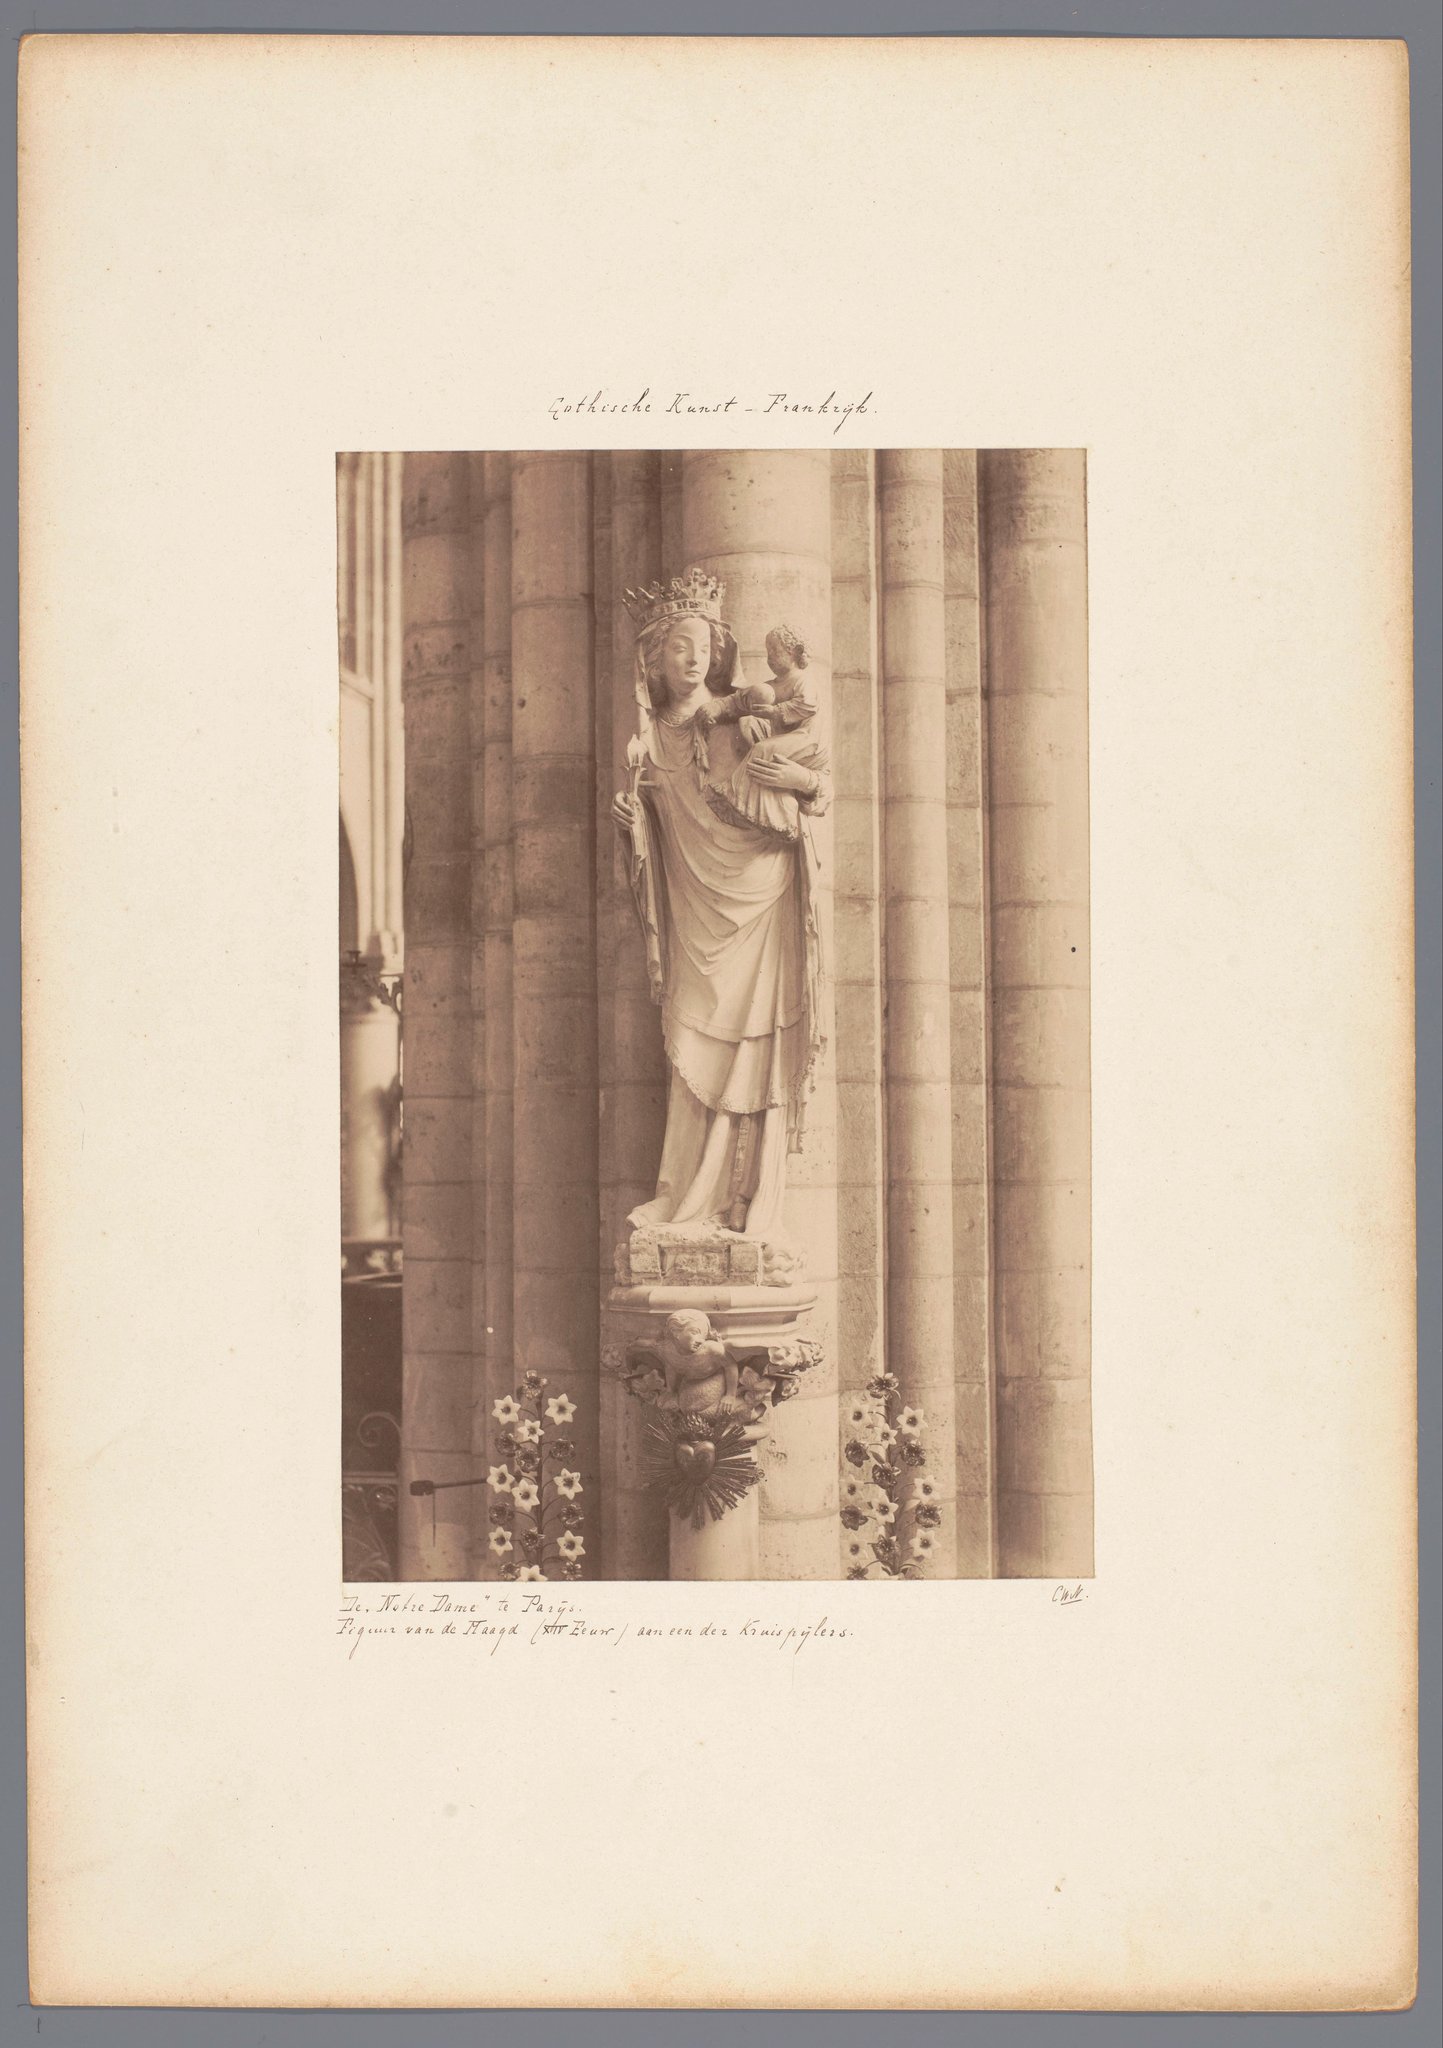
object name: photograph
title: Sculptuur van Maria met Kind in de Notre-Dame te Parijs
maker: Anonymous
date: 1875-1900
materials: cardboard, photographic support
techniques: albumen print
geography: notre-dame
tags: madonna: i.e. mary with the christ-child, piece of sculpture, reproduction of a piece of sculpture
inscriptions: inscription: ‘CWN.’, inscription: ‘Gothische Kunst - Frankrijk.’, collector's mark: ‘KUNSTNIJVERHEIDSCHOOL QUELLINUS AMSTERDAM FRANS HALSSTRAAT 14.’, collector's mark: ‘INSTITUUT VOOR KUNST-NIJVERHEIDSONDERWIJS GABRIËL METSUSTRAAT No. 16 AMSTERDAM’